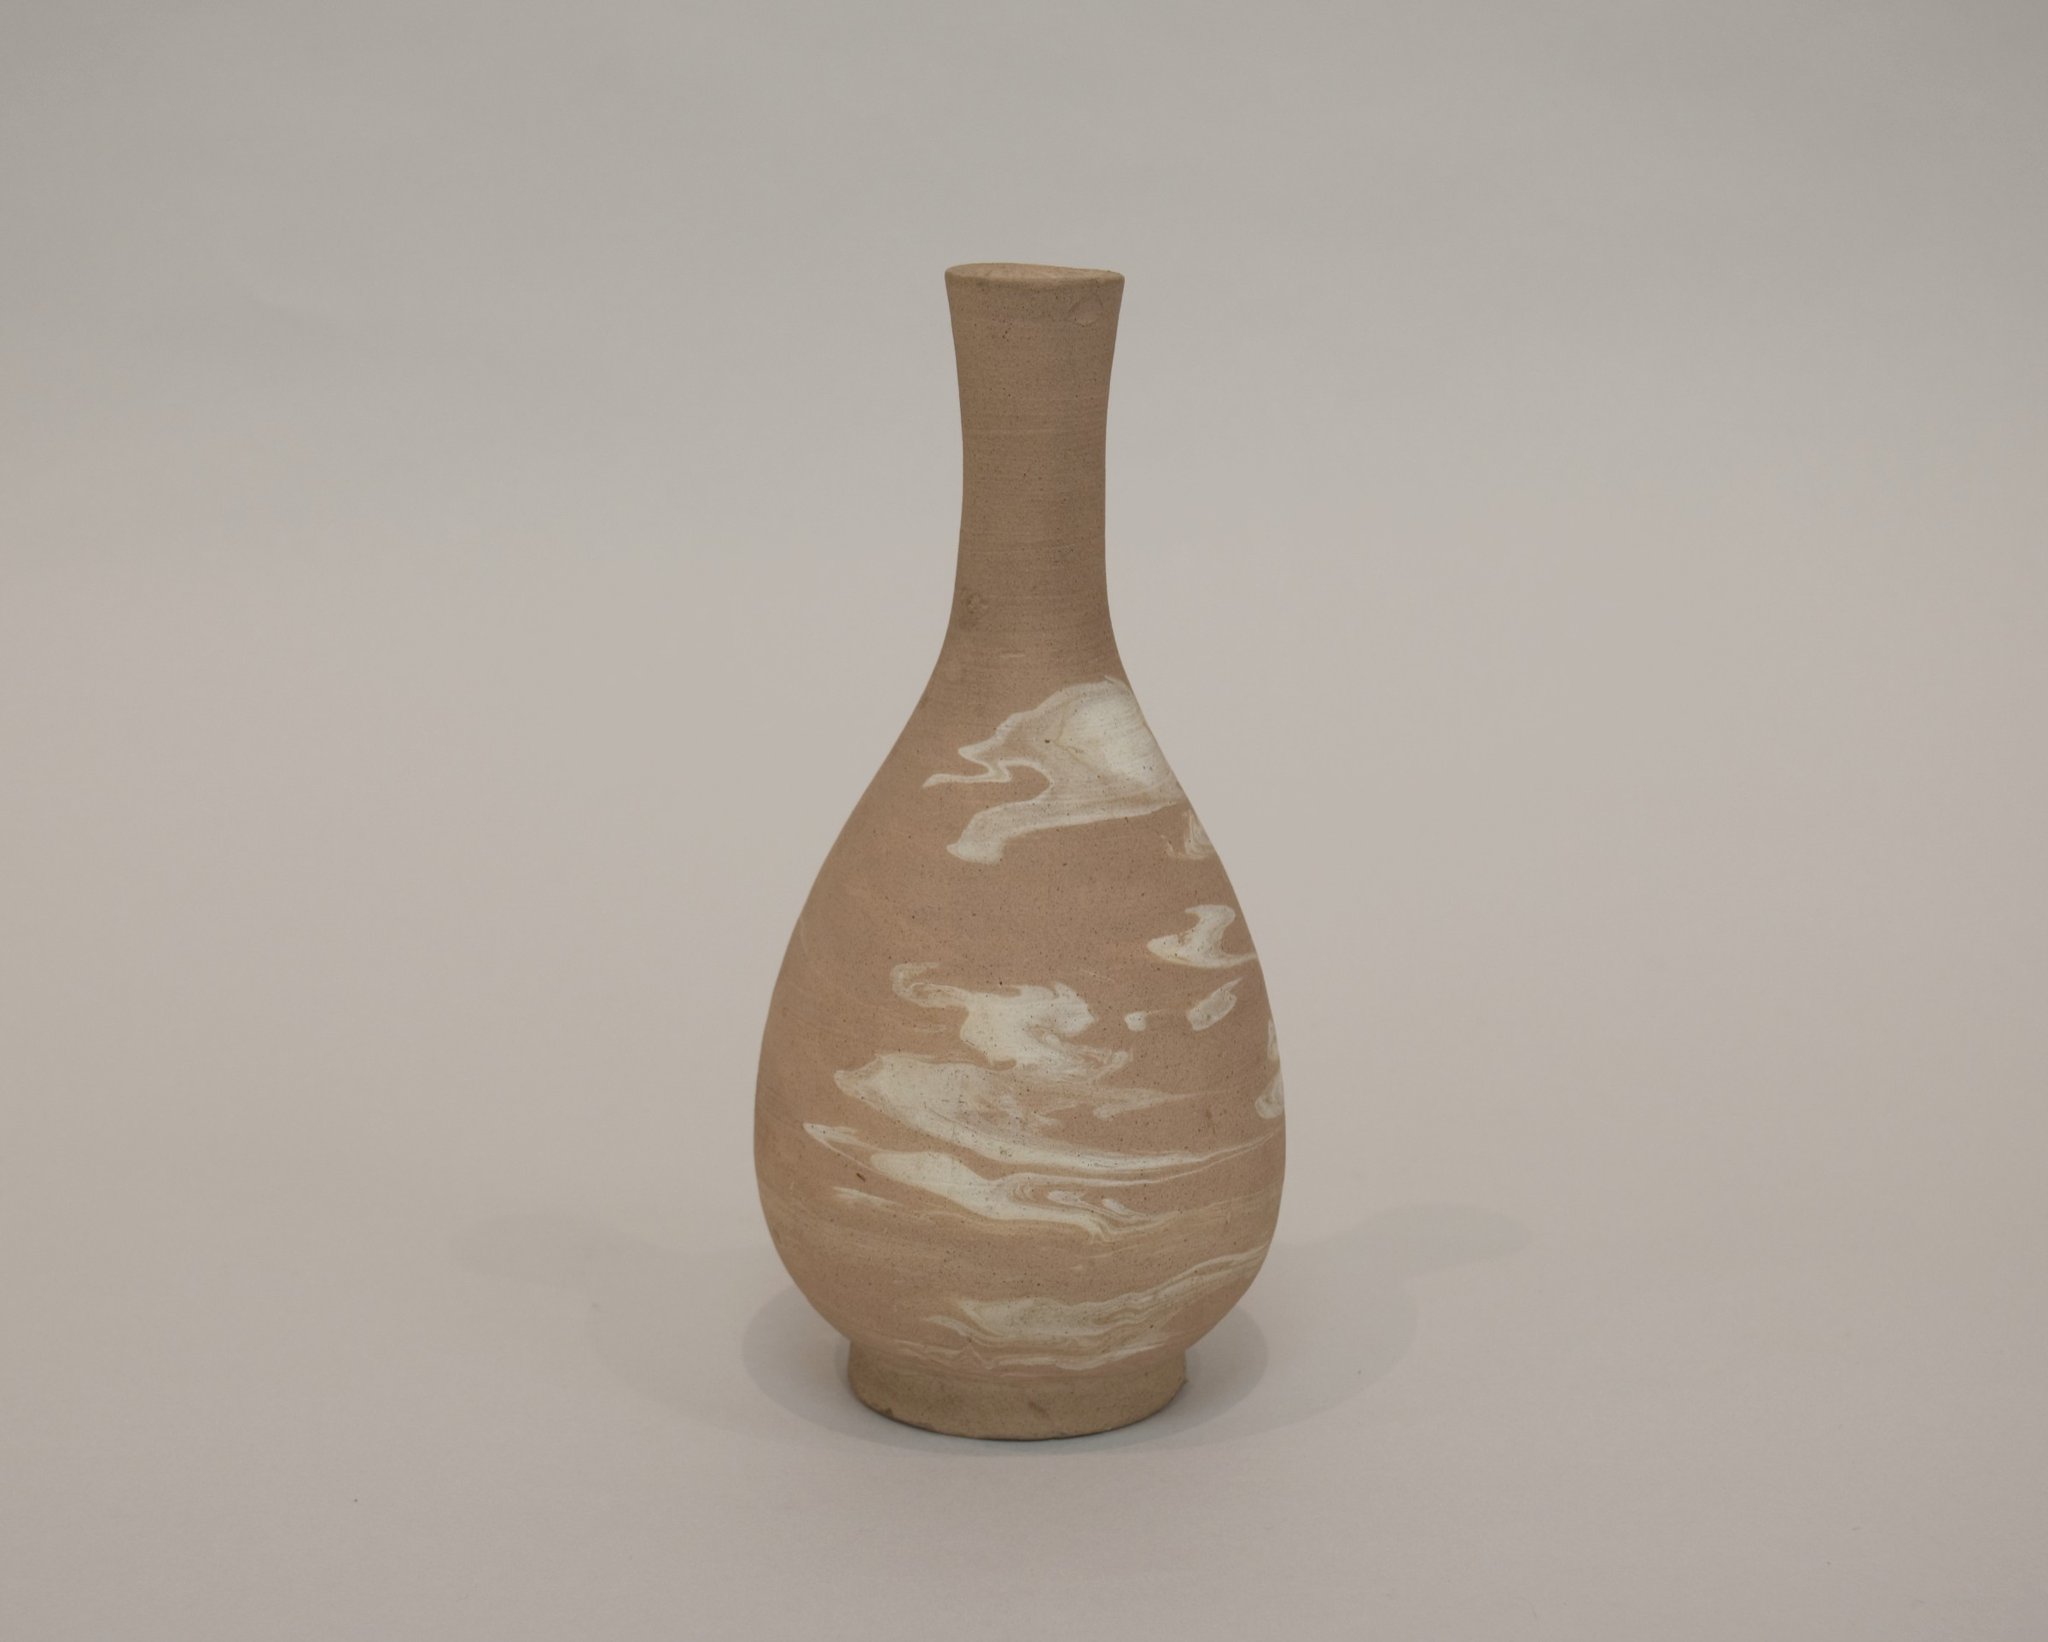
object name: vase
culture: chinese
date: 1101-1300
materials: marble, stoneware